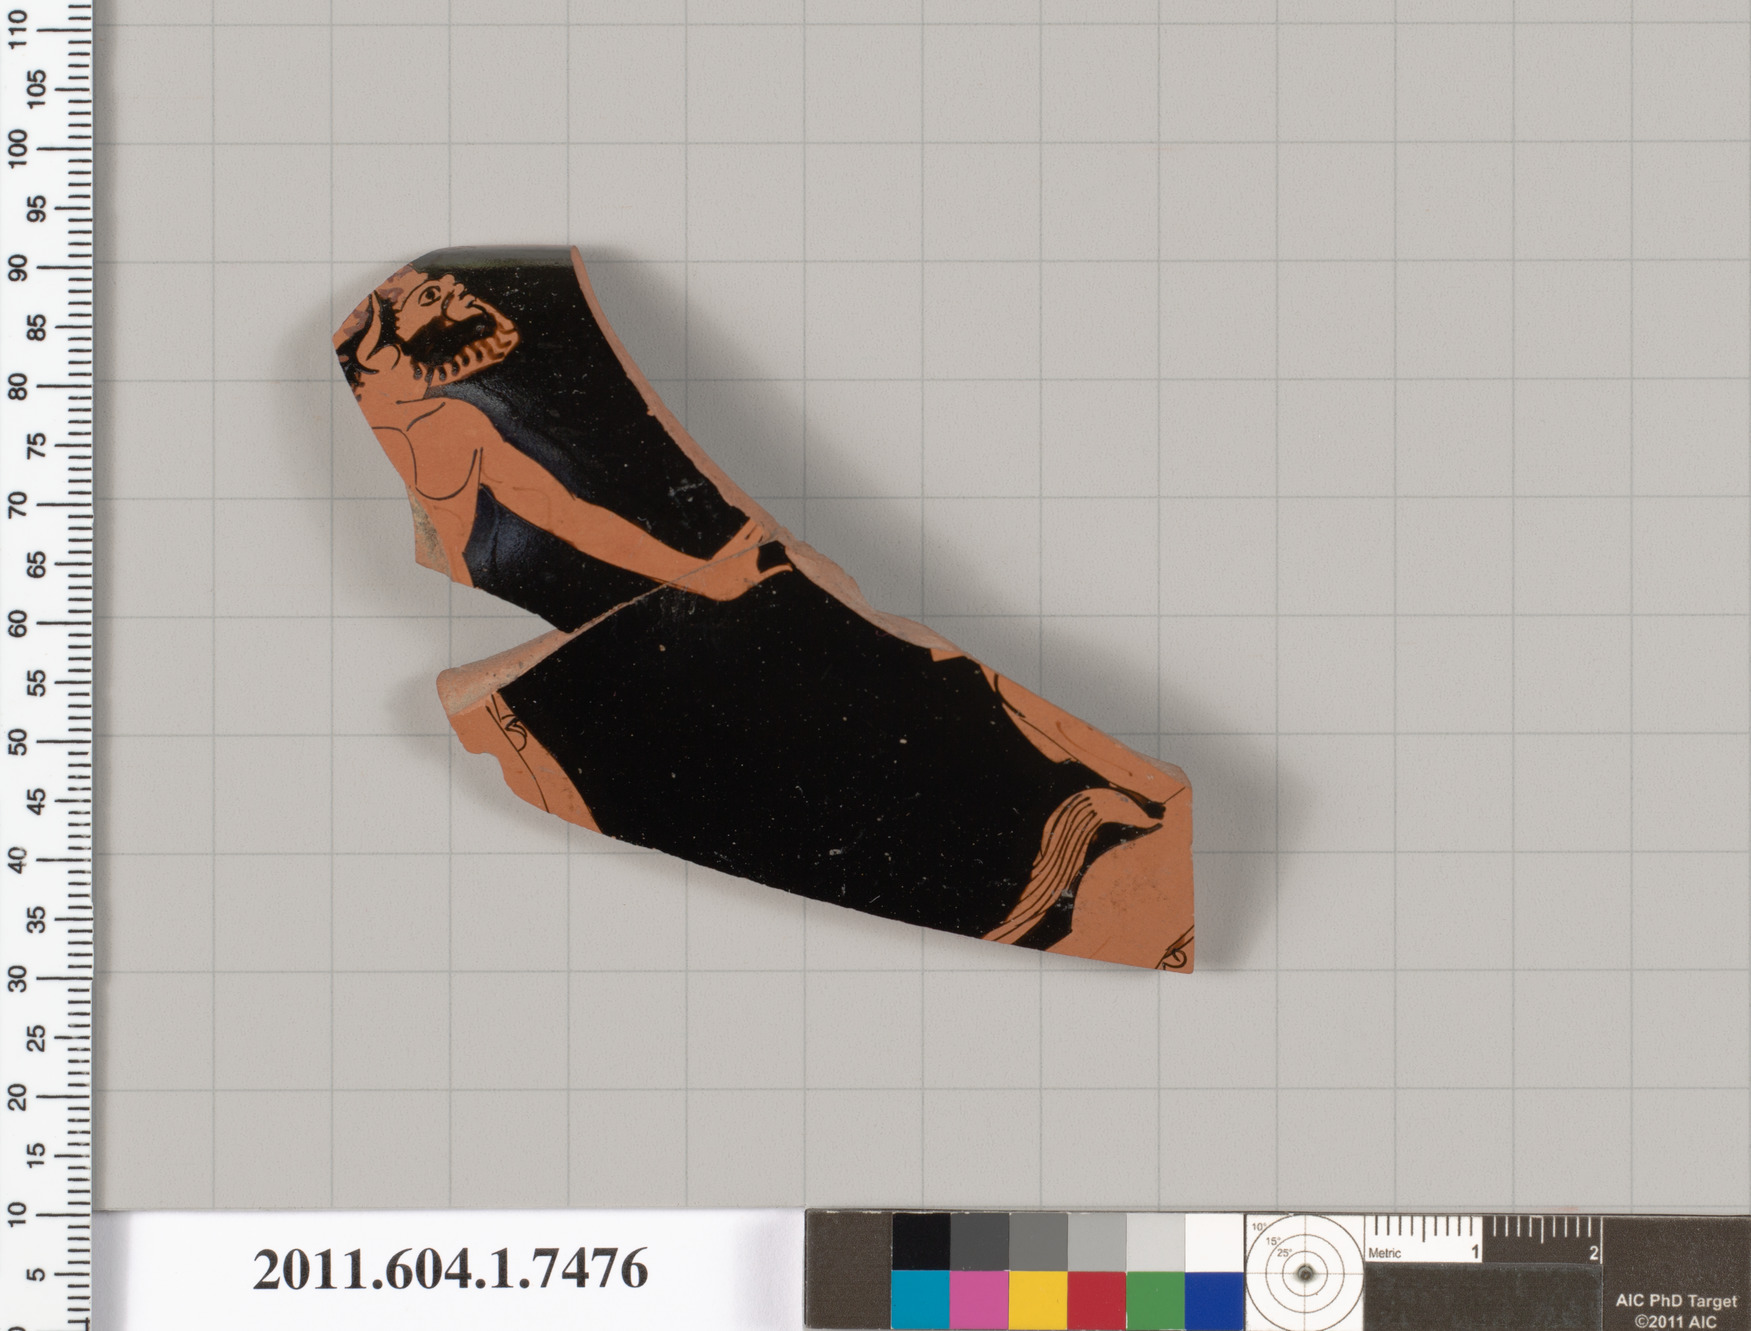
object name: kylix fragment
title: Terracotta rim fragment of a kylix (drinking cup)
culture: greek, attic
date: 470-460 BCE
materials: terracotta